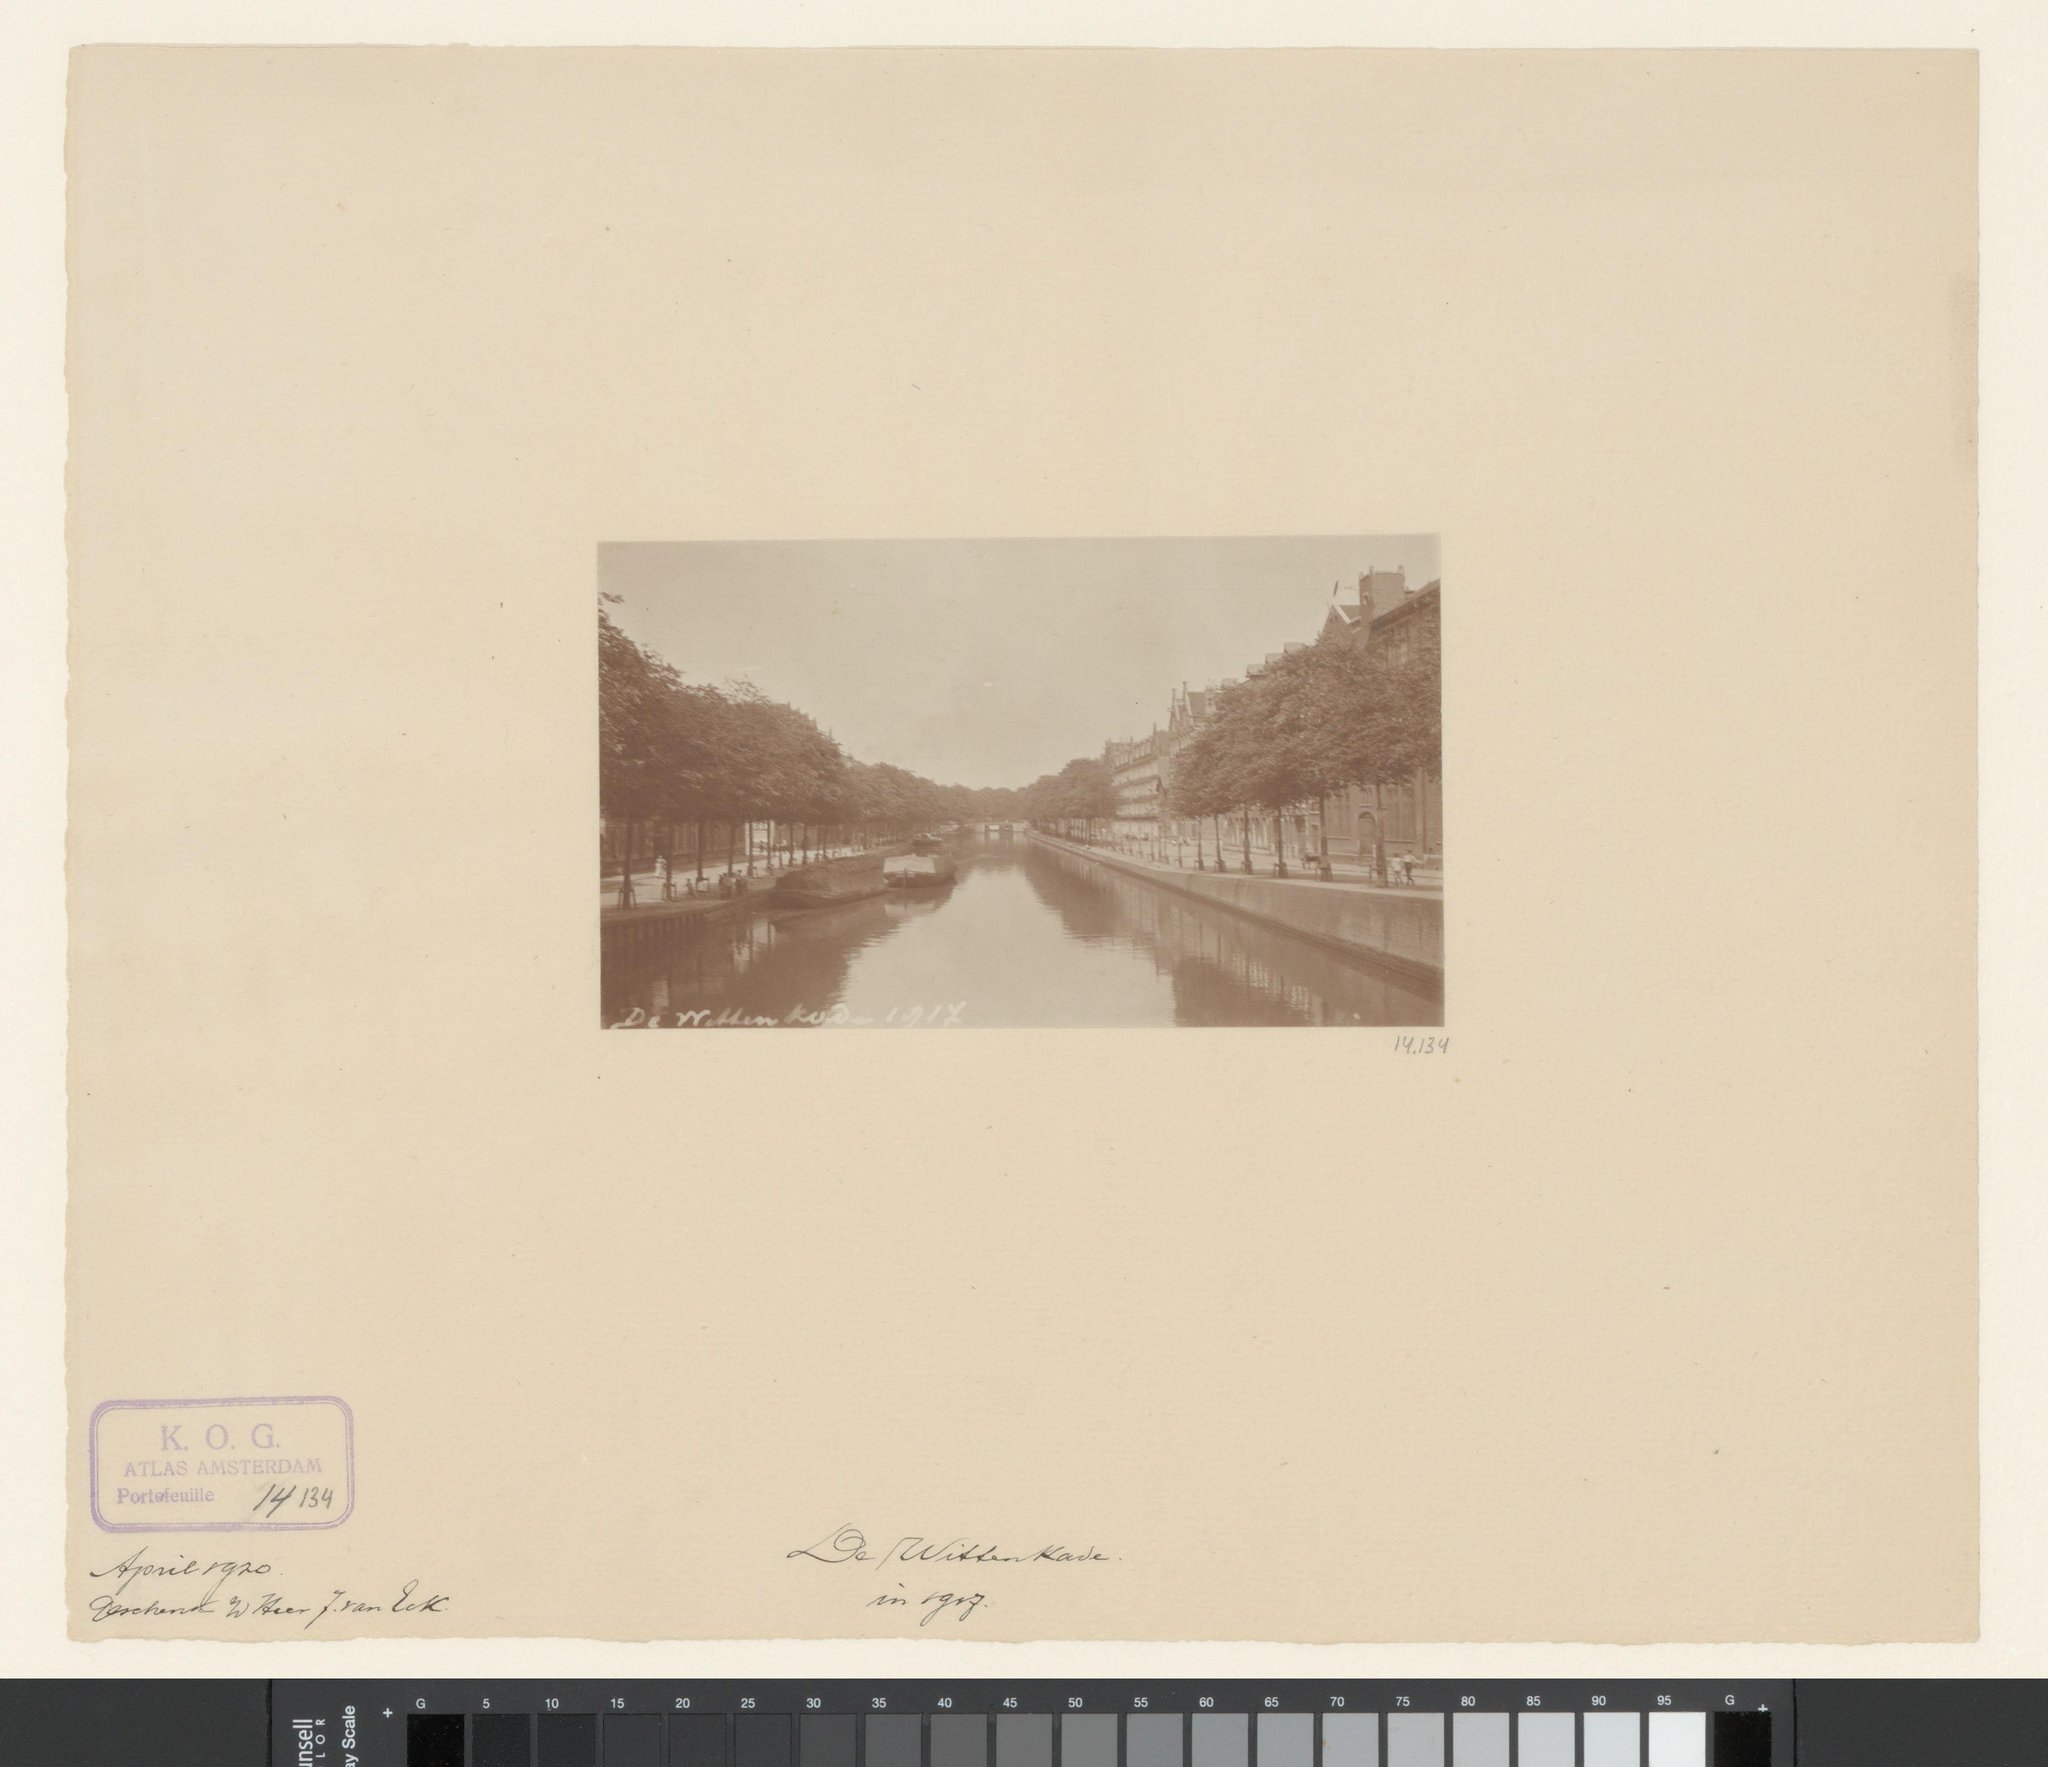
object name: photograph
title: Gezicht op de De Wittenkade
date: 1917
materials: cardboard, paper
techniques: albumen print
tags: city-view in general; 'veduta', canal, bridge in city across river, canal, etc., street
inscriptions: collector's mark: ‘14 134’ Lugt 1641b, inscription: ‘De Wittenkade / in 1917. / April 1920. / Geschenk v/d Heer J. van Eck.’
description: Onderwerpsrubriek binnen de Atlas Amsterdam: Waal (Kromme en Oude), Walenpleintje, Warmoesgracht, Warmoesstraat, Waterlooplein, Westerdoksdijk, Westermarkt, Weteringschans, Willemspark, Willemsstraat, Wittenburg, Wittenkade (de), Wittenstraat (de).